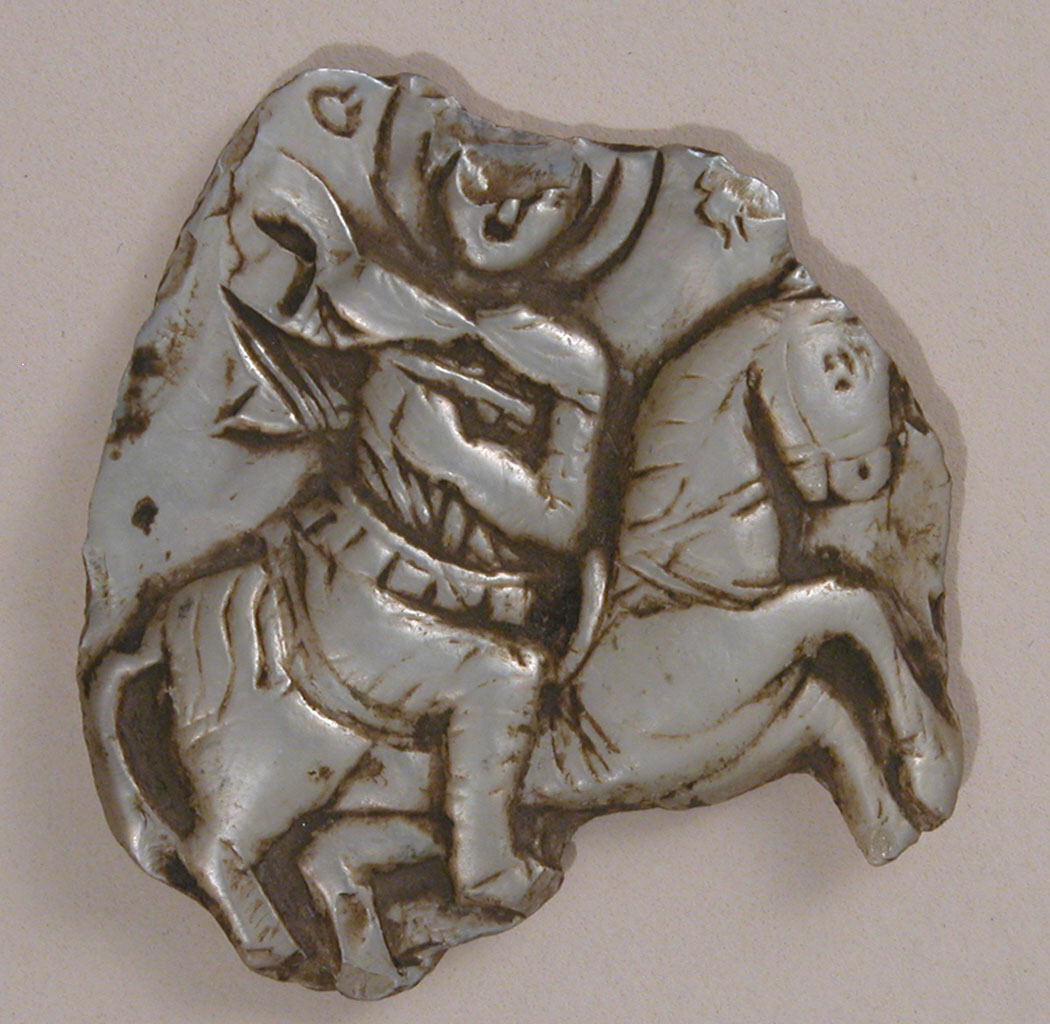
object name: pendant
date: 201-1200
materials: mother of pearl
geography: egypt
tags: horses